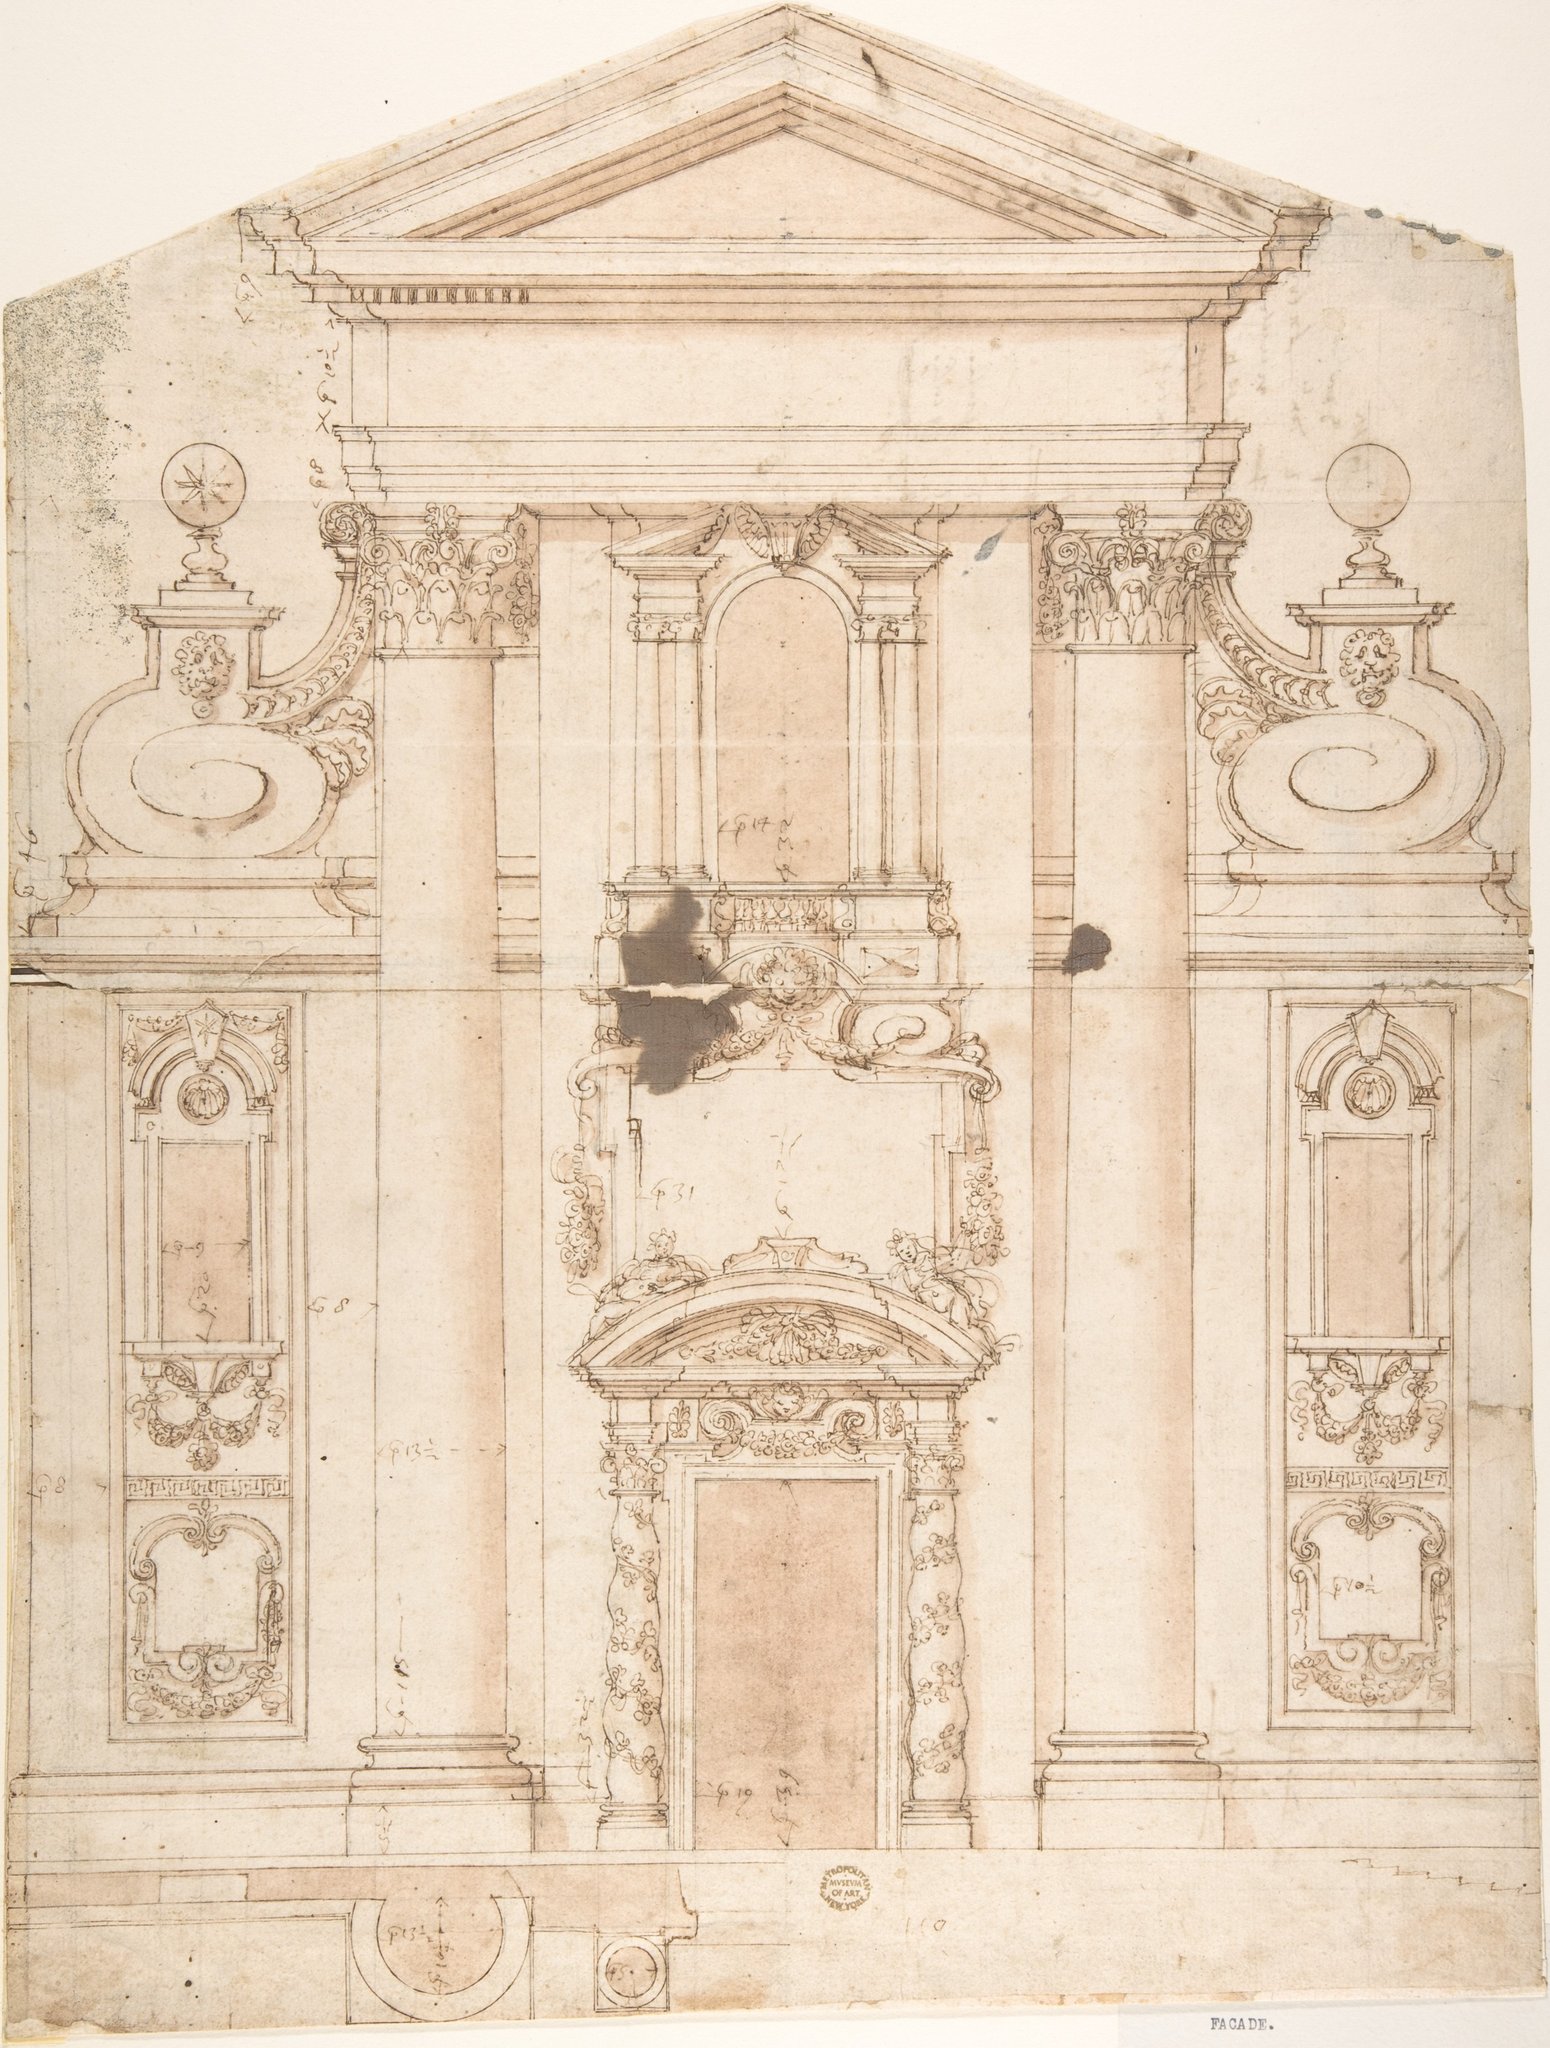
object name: drawing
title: Project for a Church Façade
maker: anonymous, italian, 17th century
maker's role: artist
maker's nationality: italian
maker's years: 1600-1700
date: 1601-1700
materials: ink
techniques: pen, tinting, wash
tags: architecture,churches